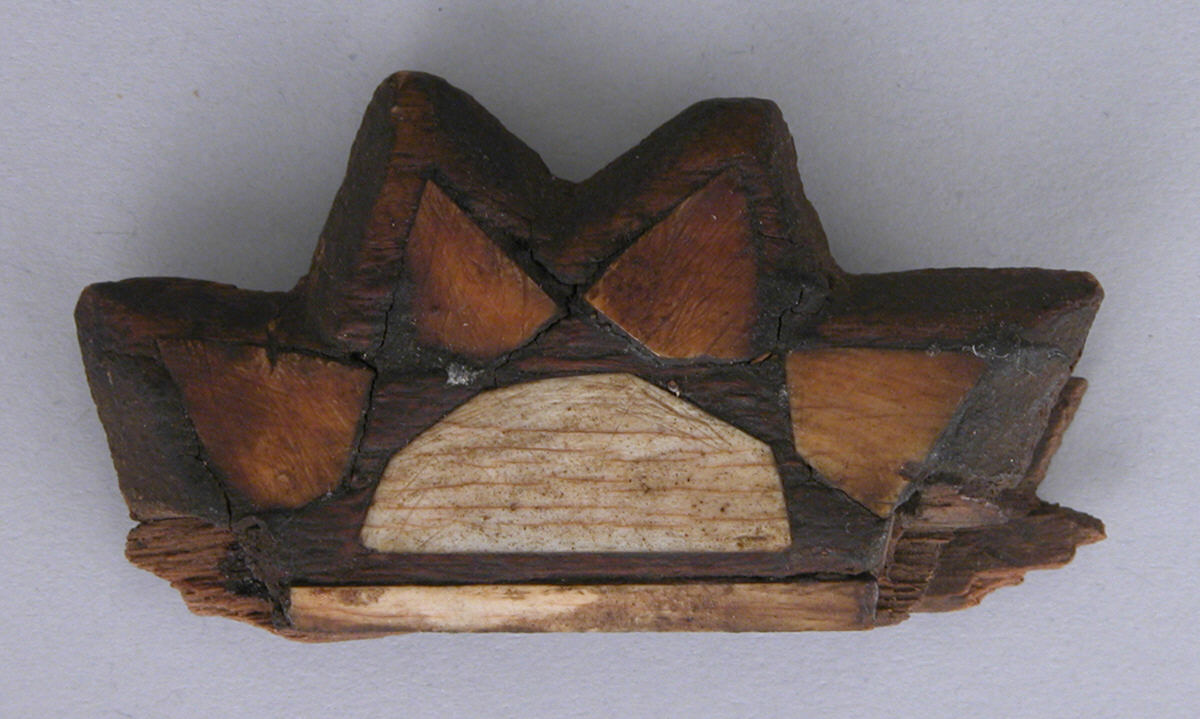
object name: panel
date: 1301-1500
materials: ivory, wood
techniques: inlay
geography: egypt